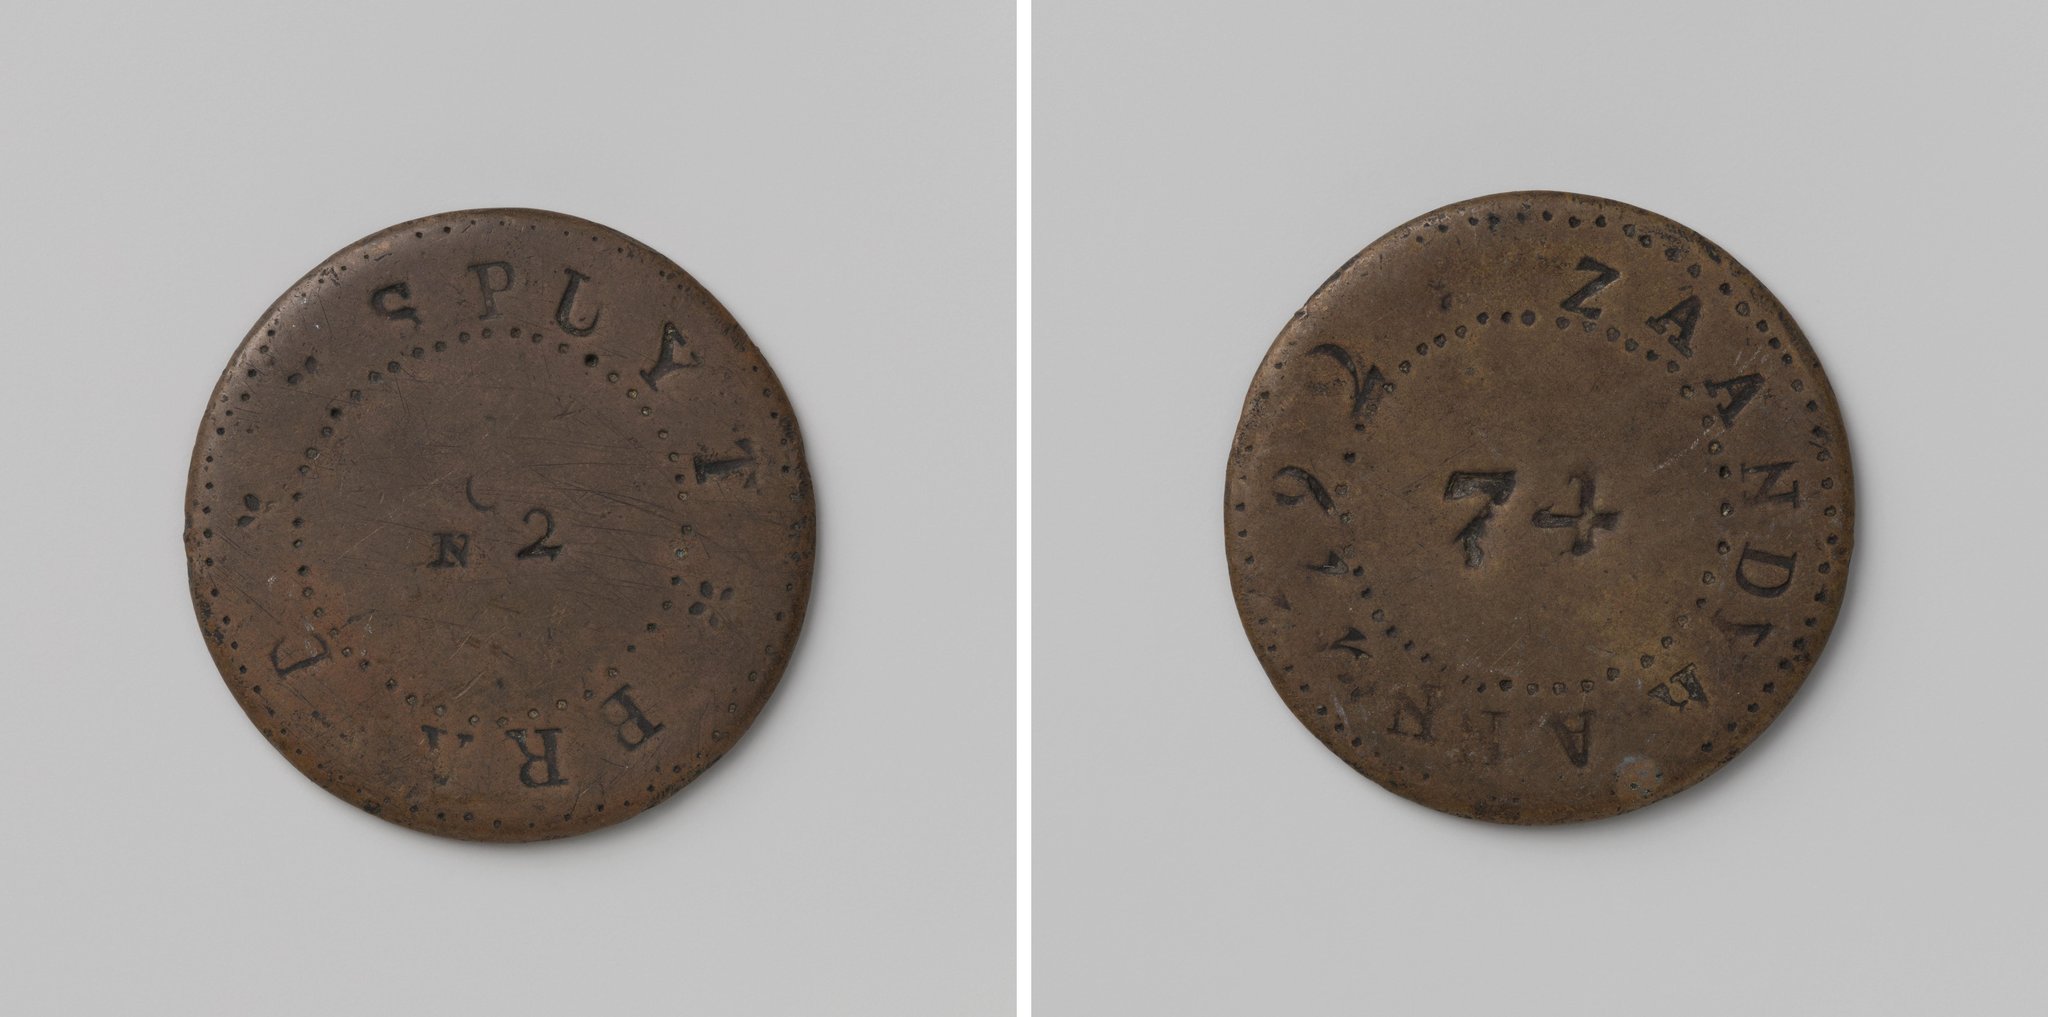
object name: medal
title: Zaandijk, brandspuitpenning van spuit 2 met nummer 74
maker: Anonymous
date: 1792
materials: brass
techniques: engraving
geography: zaandijk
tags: zaandijk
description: Messing penning. Voorzijde: cijfer 2 binnen omschrift. Keerzijde: cijfer 74 binnen omschrift